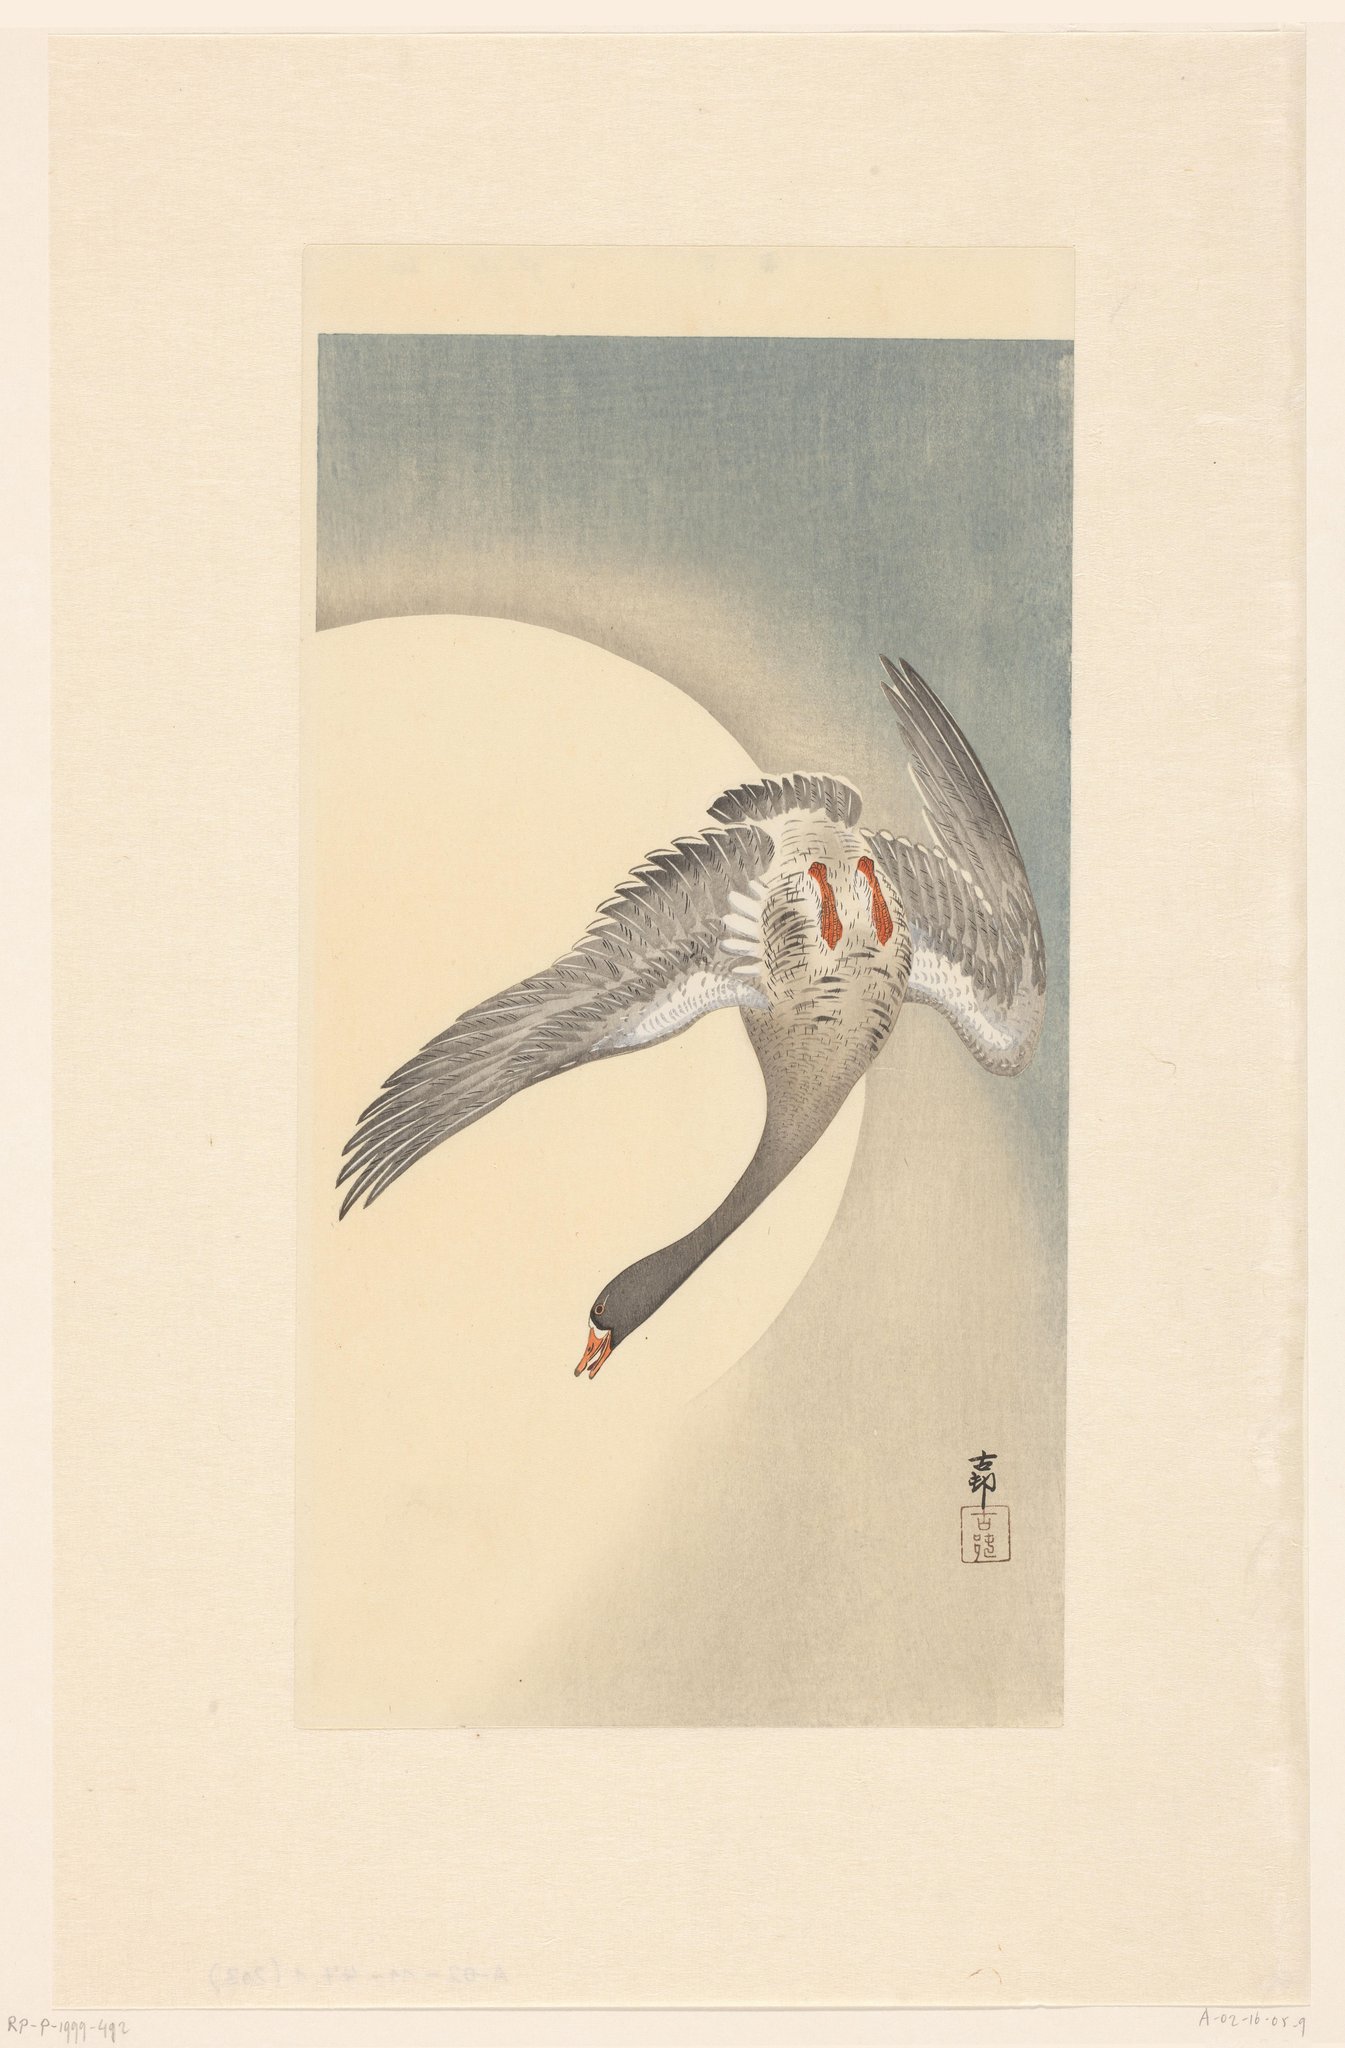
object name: print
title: Kolgans bij volle maan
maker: ohara koson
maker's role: print maker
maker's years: 1877-1945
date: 1900-1936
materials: paper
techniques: woodcut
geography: japan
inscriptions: collector's mark: Lugt 2228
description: Kolgans in vlucht, van onderen gezien, bij grote volle maan.